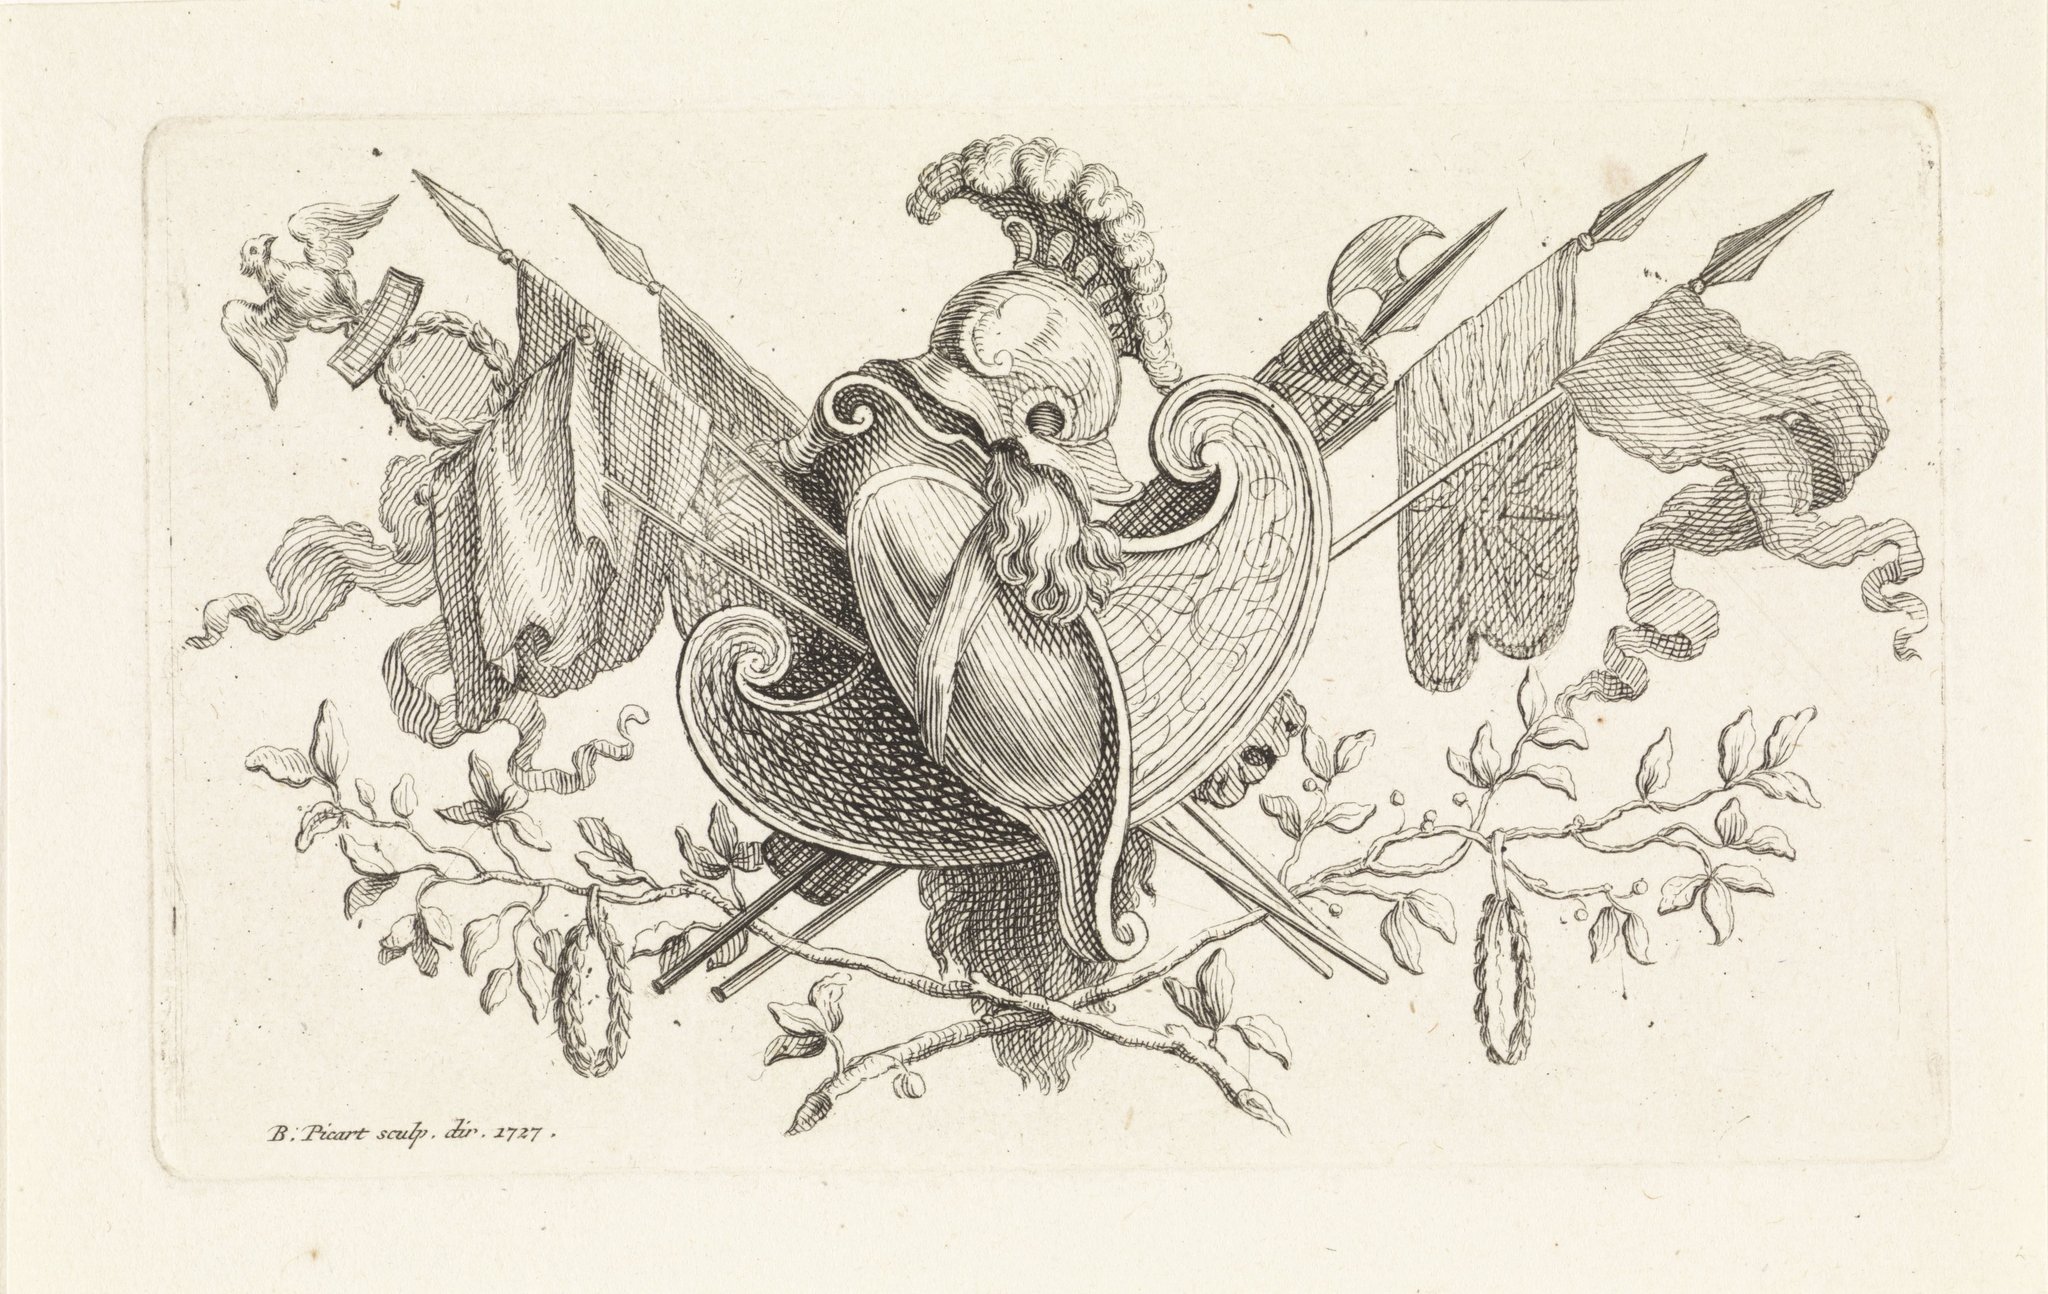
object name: print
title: Ornament met wapentuig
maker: bernard picart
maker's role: draughtsman, print maker, publisher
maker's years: 1673-1733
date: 1727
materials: paper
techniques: engraving, etching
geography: amsterdam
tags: coat of arms (as symbol of the state, etc.), trophy, i.e.: decorative arrangement of symbolic or typical objects ~ ornament, foliage, tendrils, branches ~ ornament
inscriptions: collector's mark: Lugt 2228